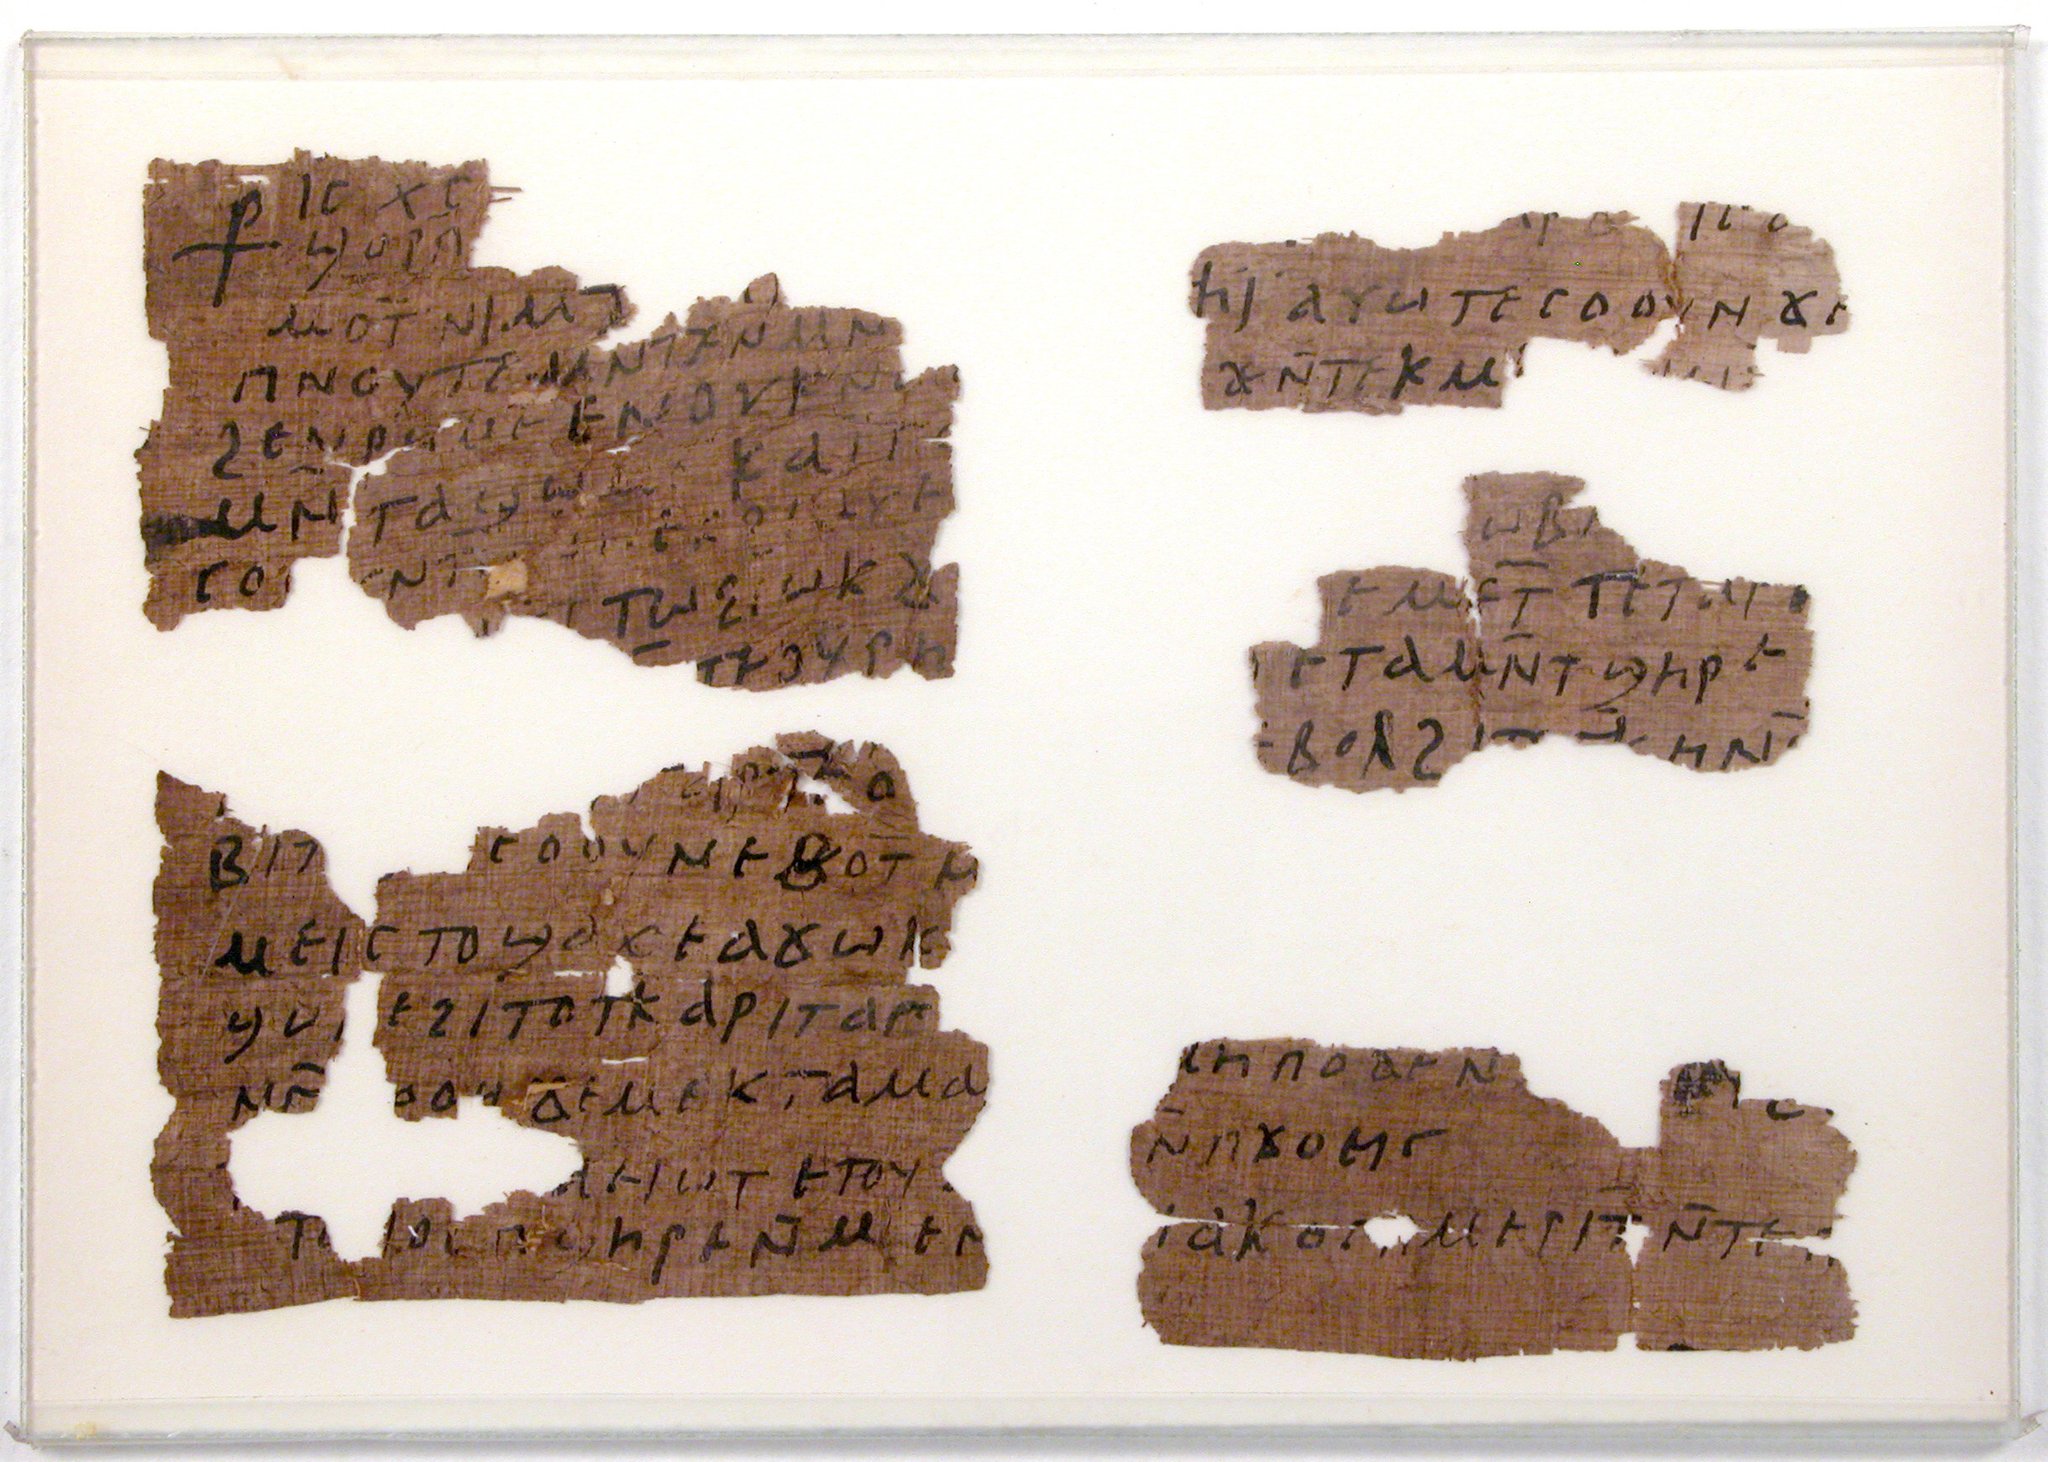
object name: fragment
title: Papyrus Fragments of a Letter to Cyriacus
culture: coptic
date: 601-700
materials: ink, papyrus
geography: egypt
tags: coptic,documents